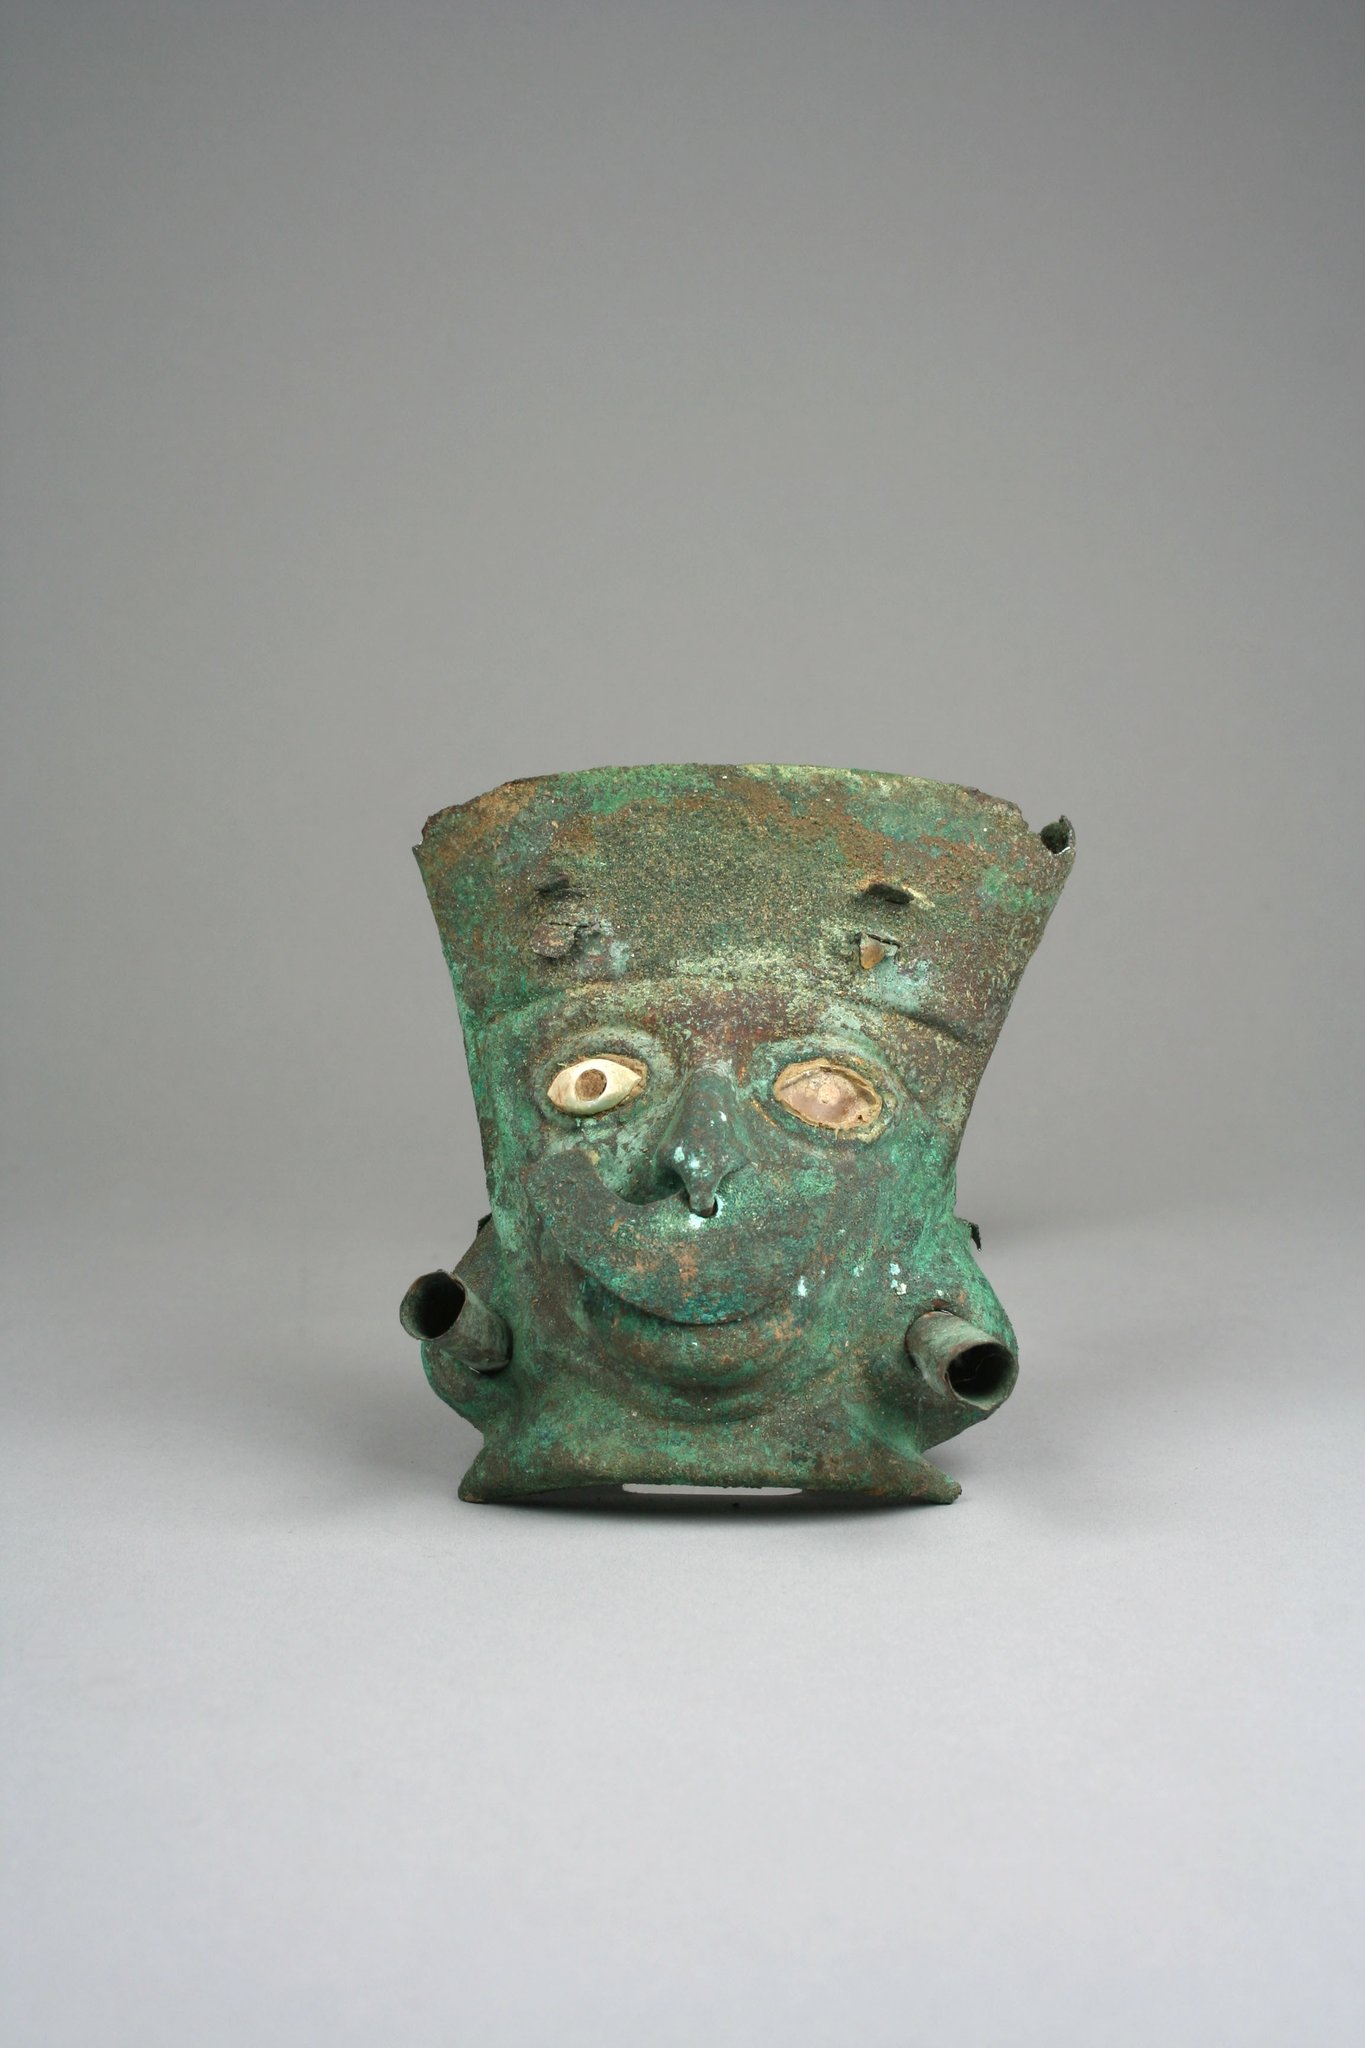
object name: ornament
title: Face Mask Ornament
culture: moche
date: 501-700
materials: gilt copper, shell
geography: peru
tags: masks